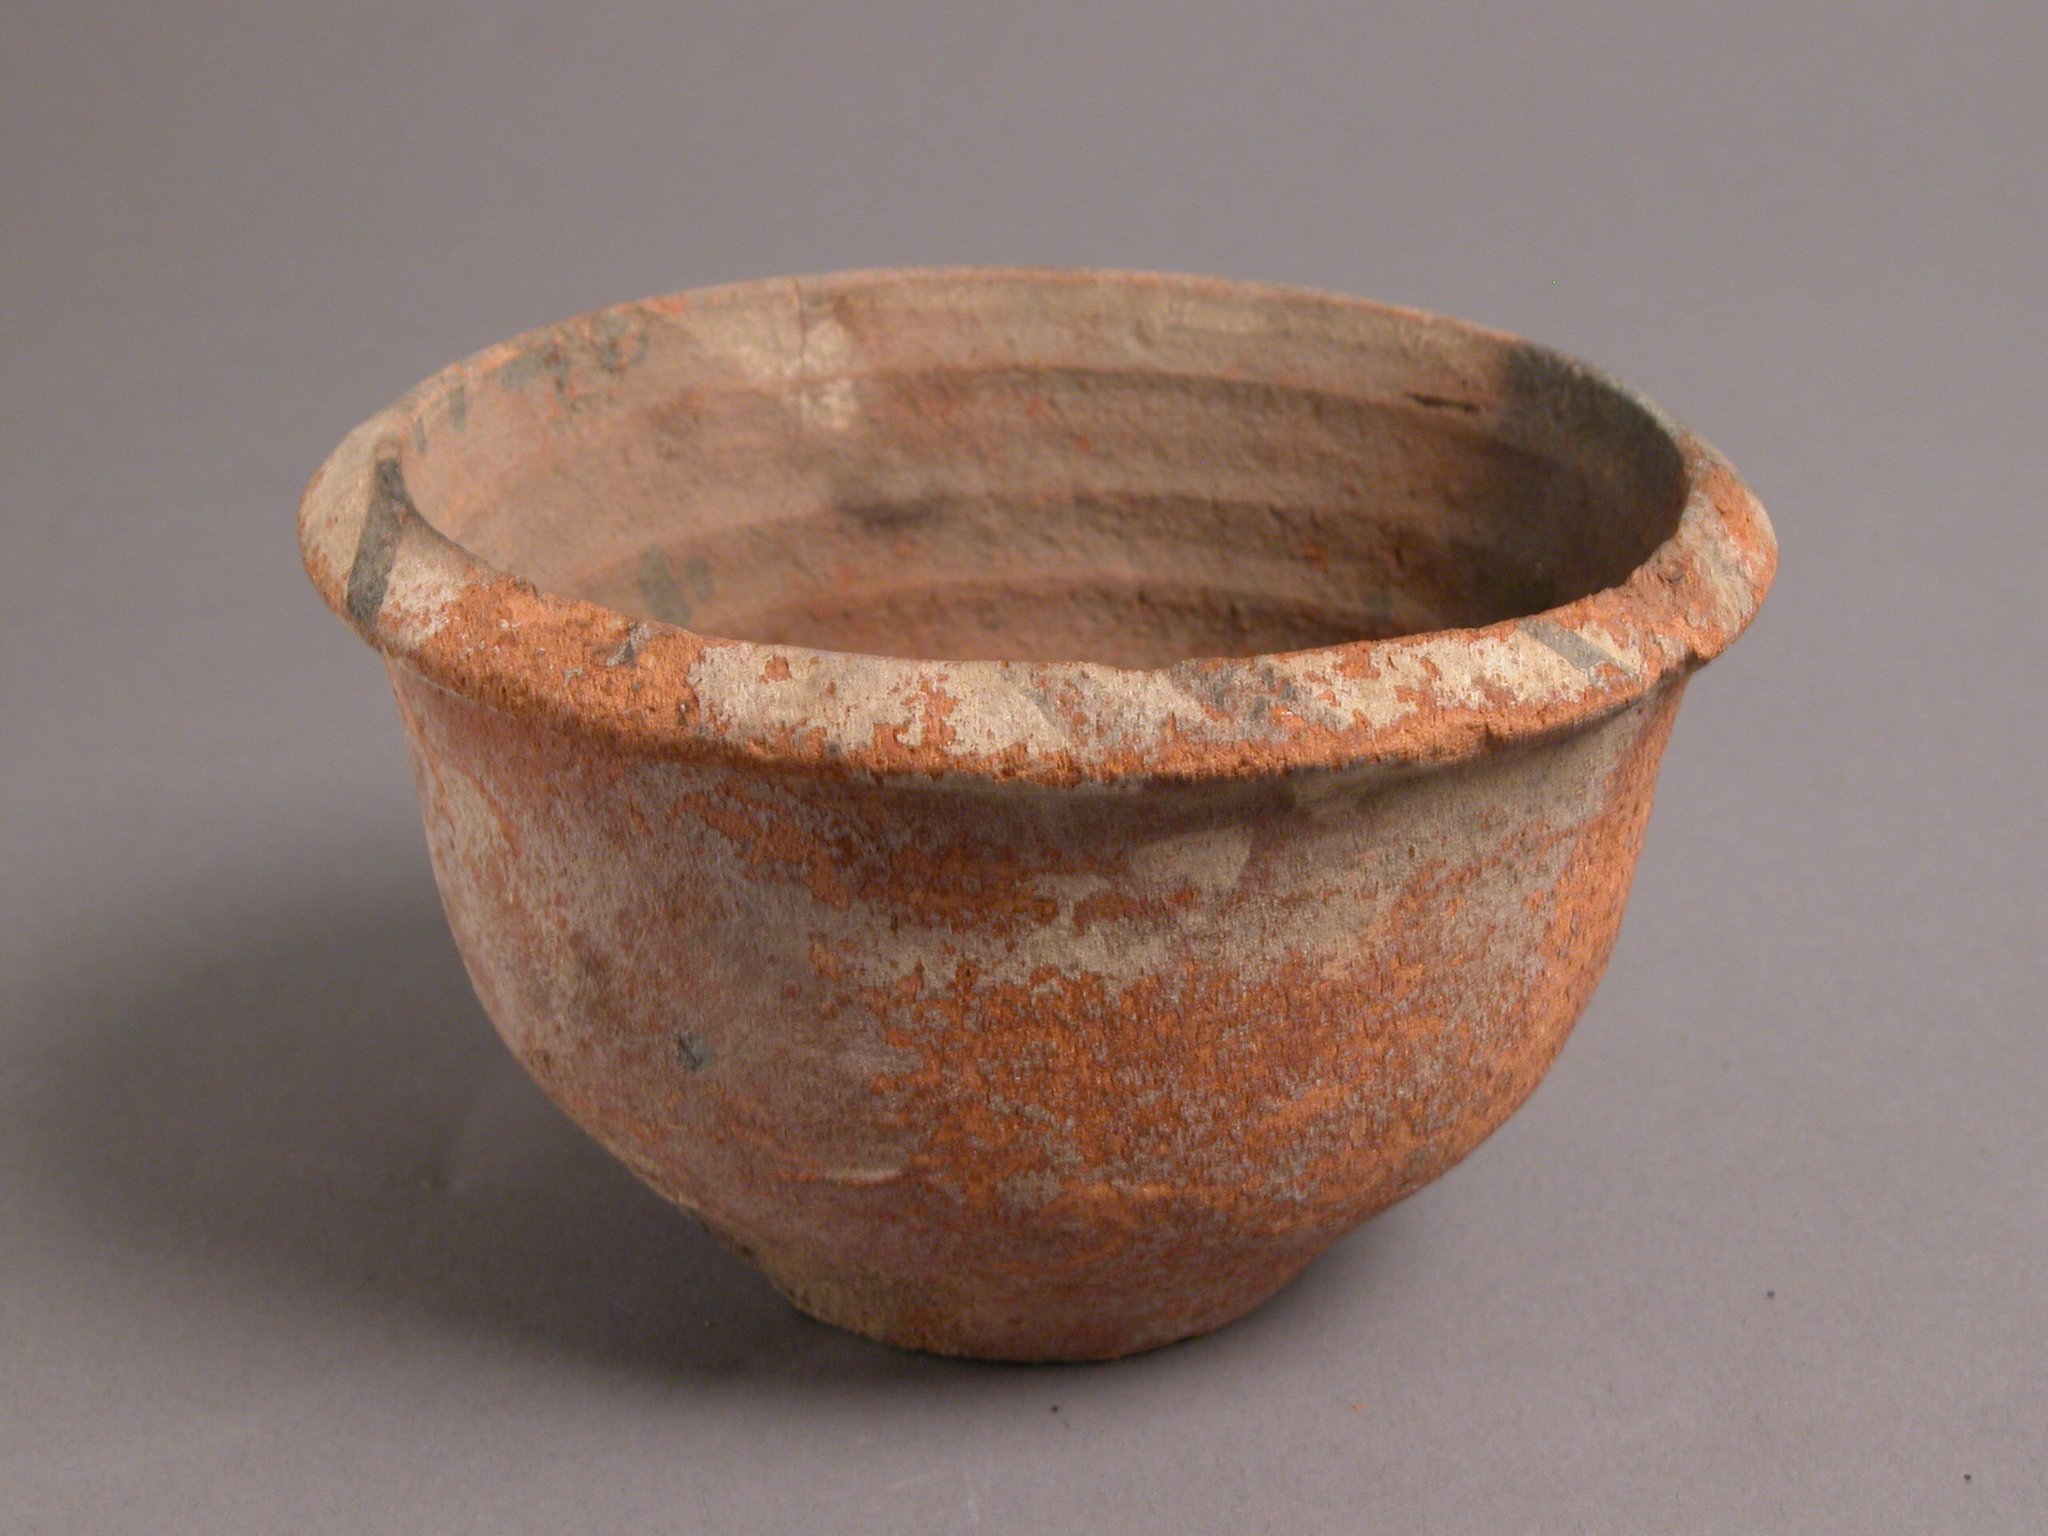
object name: bowl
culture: coptic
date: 301-700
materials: earthenware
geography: egypt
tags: bowls